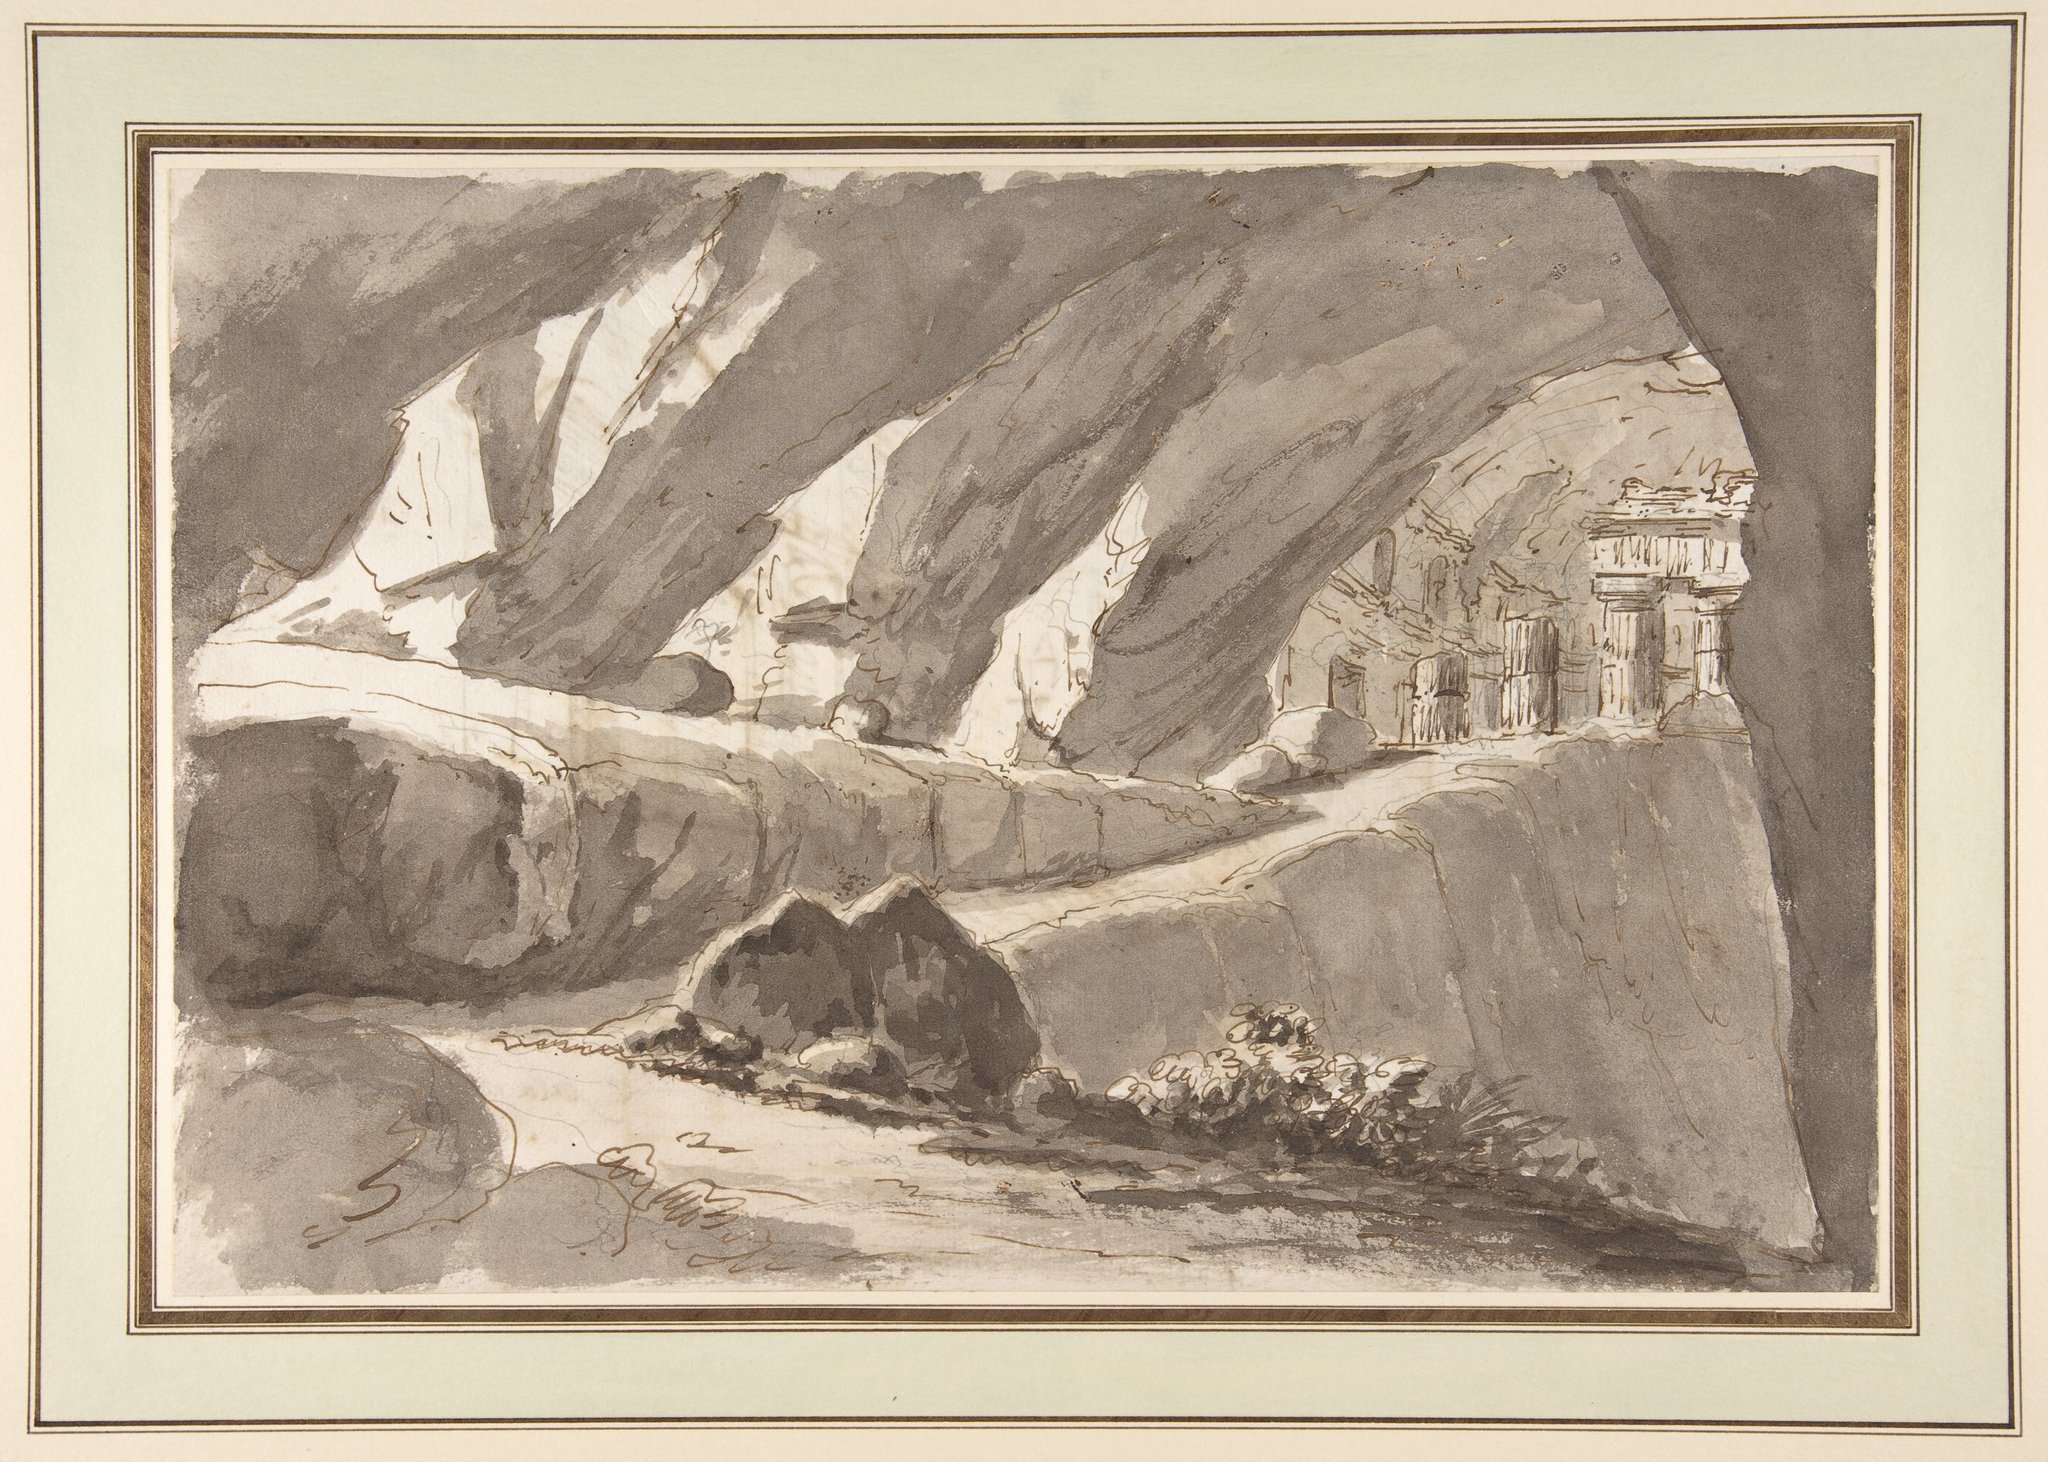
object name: drawing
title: Design for a Stage Set (recto); Architectural Design (verso)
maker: francesco navone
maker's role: artist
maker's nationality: italian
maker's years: -1804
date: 1780-1804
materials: chalk, ink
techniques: brush, pen, wash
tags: stage design